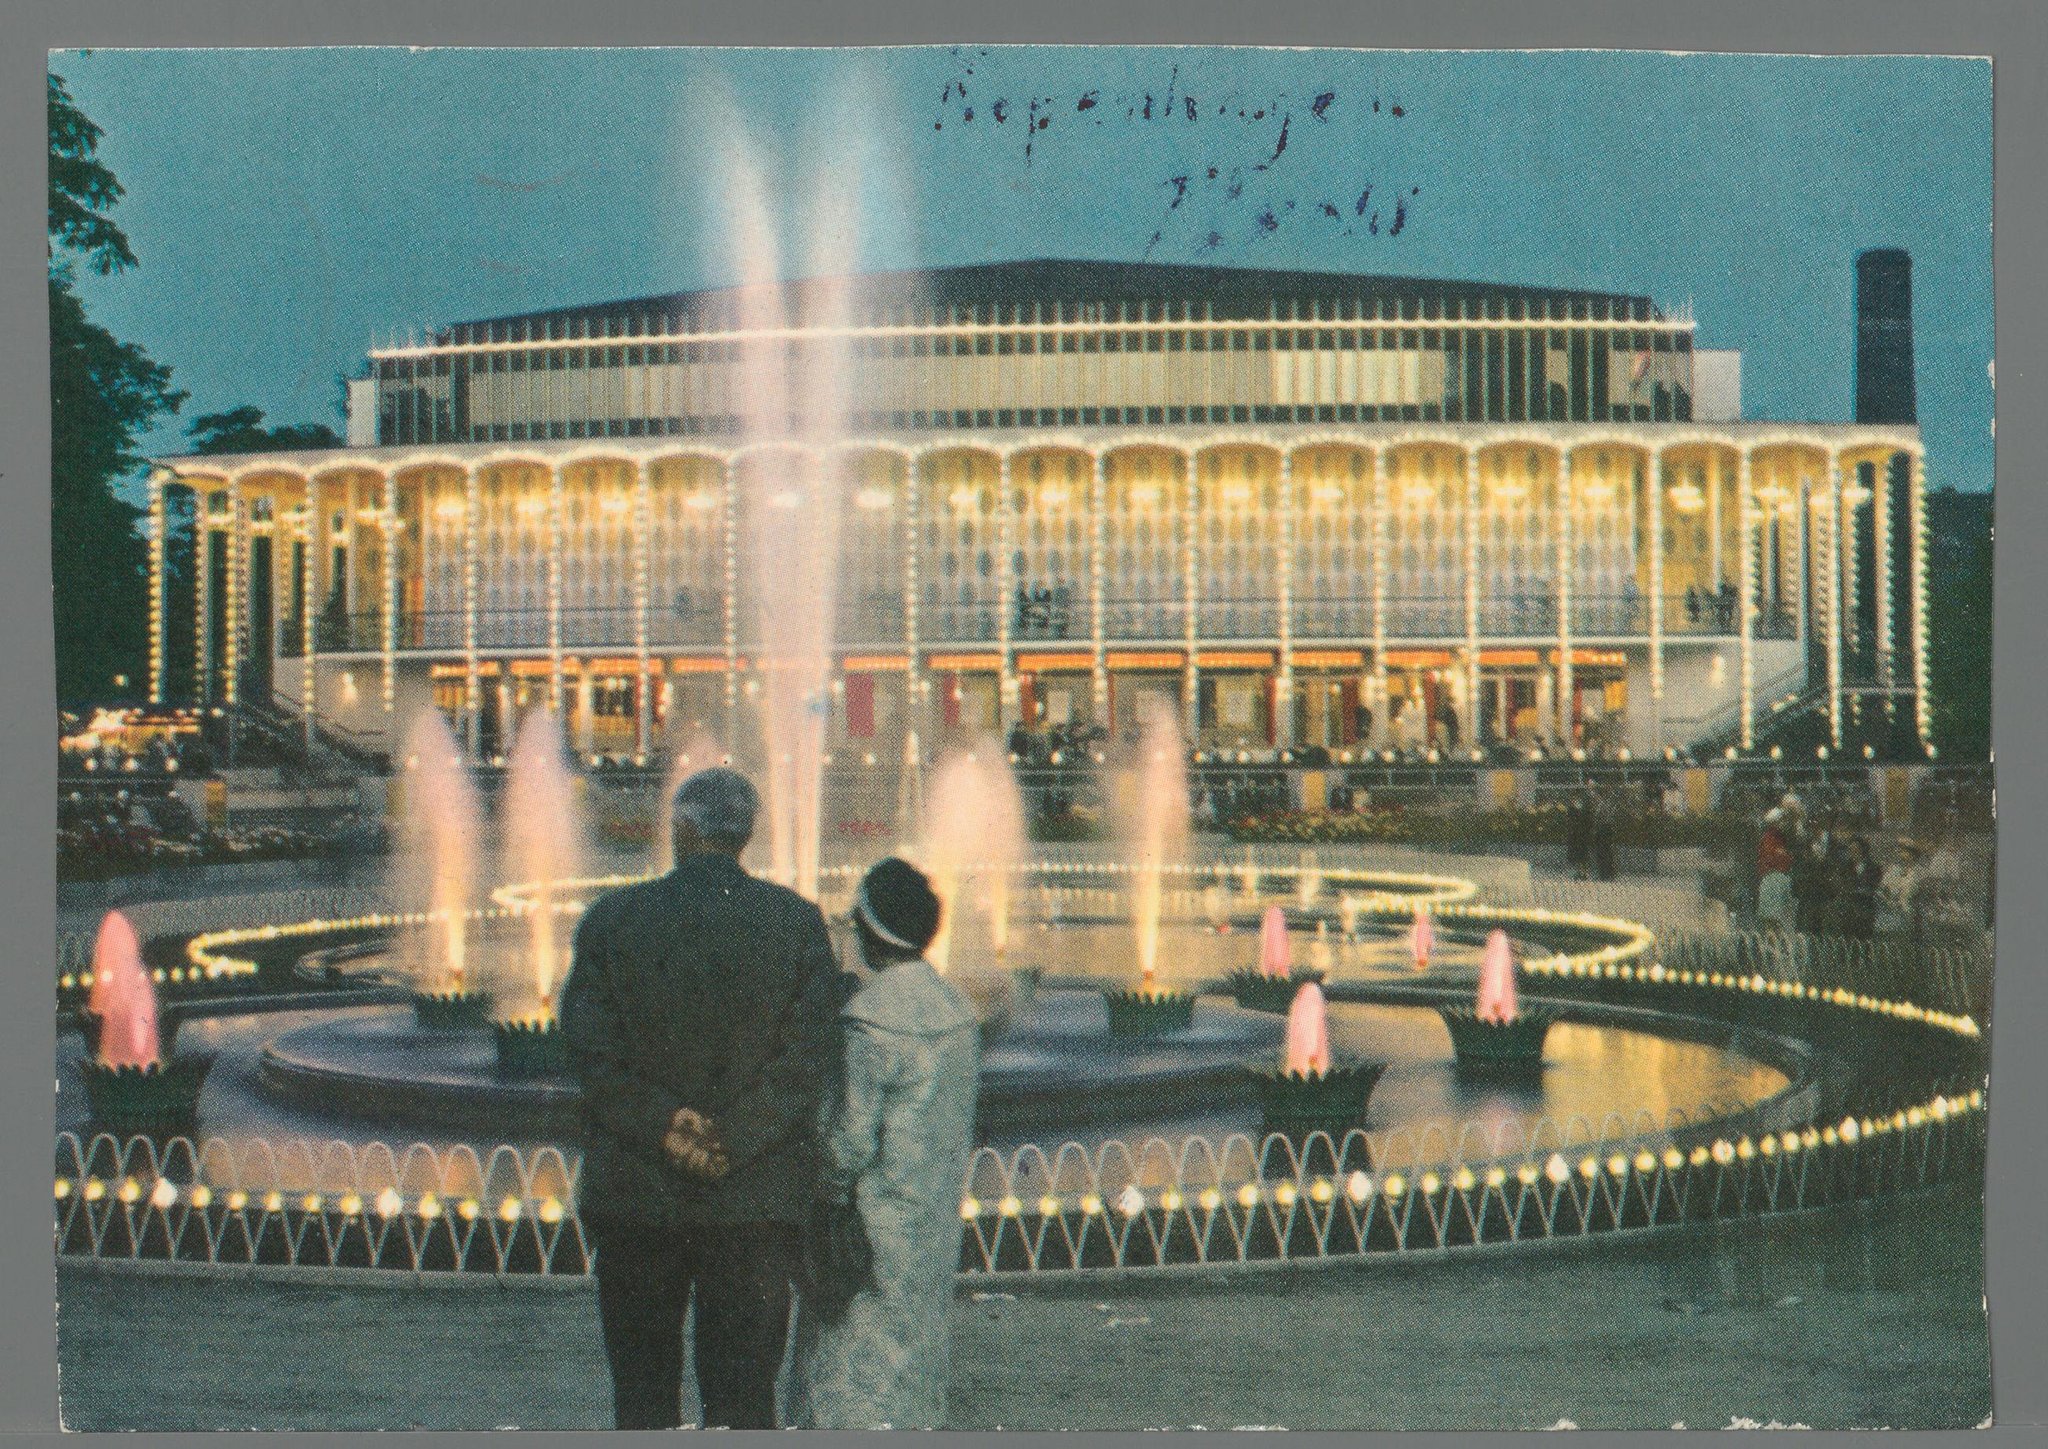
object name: photomechanical print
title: Copenhagen. The Concert-Hall in Tivoli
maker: Anonymous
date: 1955-1977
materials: cardboard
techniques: offset printed, writing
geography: denmark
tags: public gardens, park (+ city(-scape) with figures, staffage), garden fountain, concert hall, copenhagen (city)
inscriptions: poststempel, verso, gestempeld